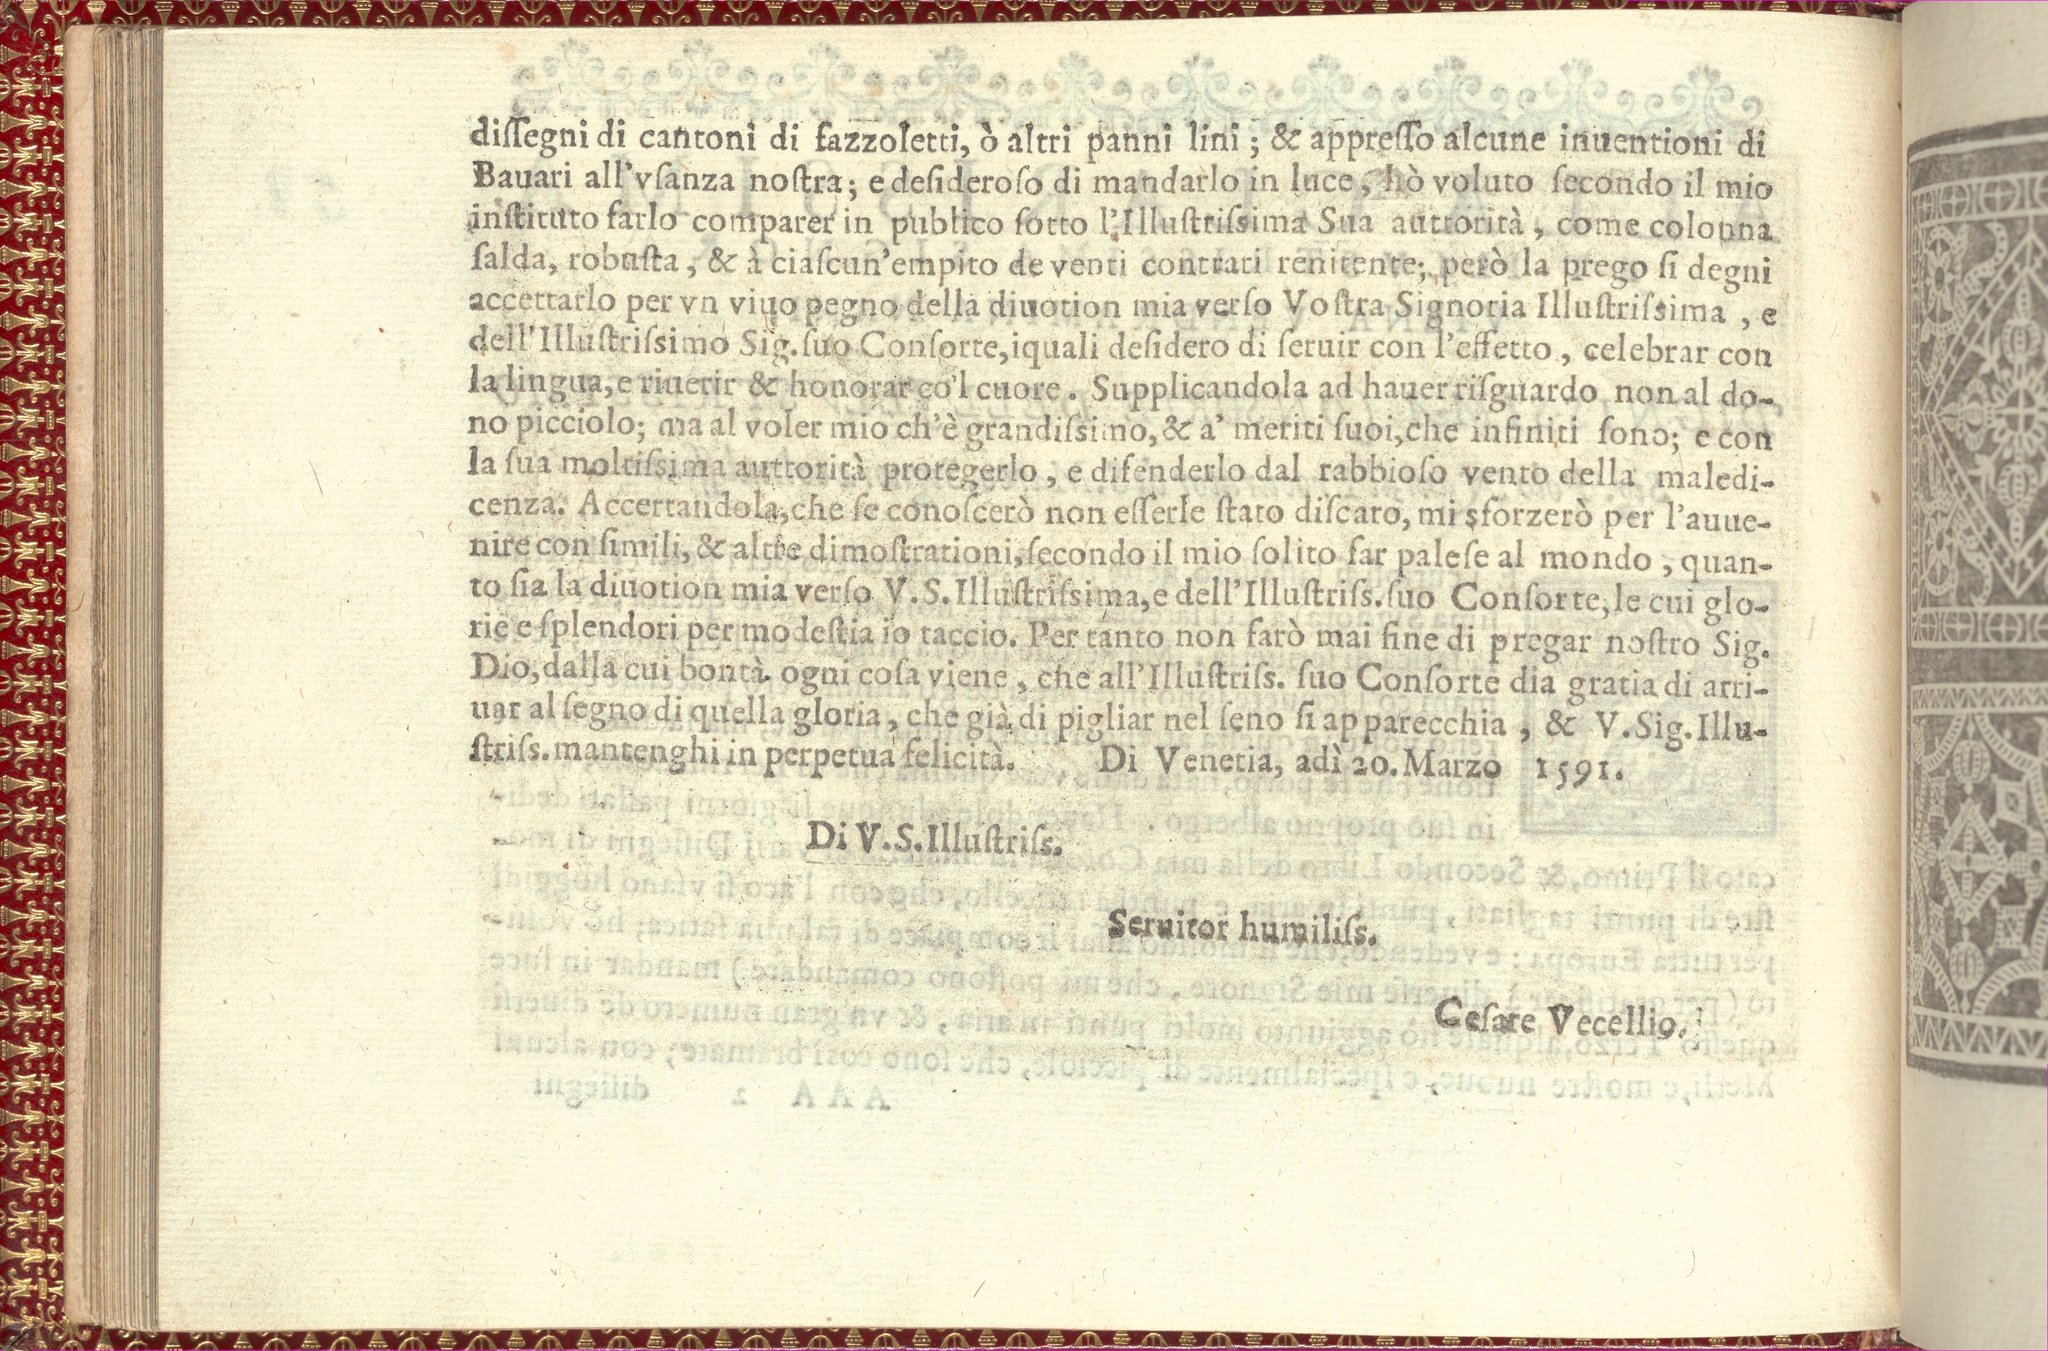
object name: book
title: Corona delle Nobili et Virtuose Donne: Libro I-IV, page 58 (verso)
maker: cesare vecellio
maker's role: publisher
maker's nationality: italian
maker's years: 1521-1601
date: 1601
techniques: woodcut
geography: italy